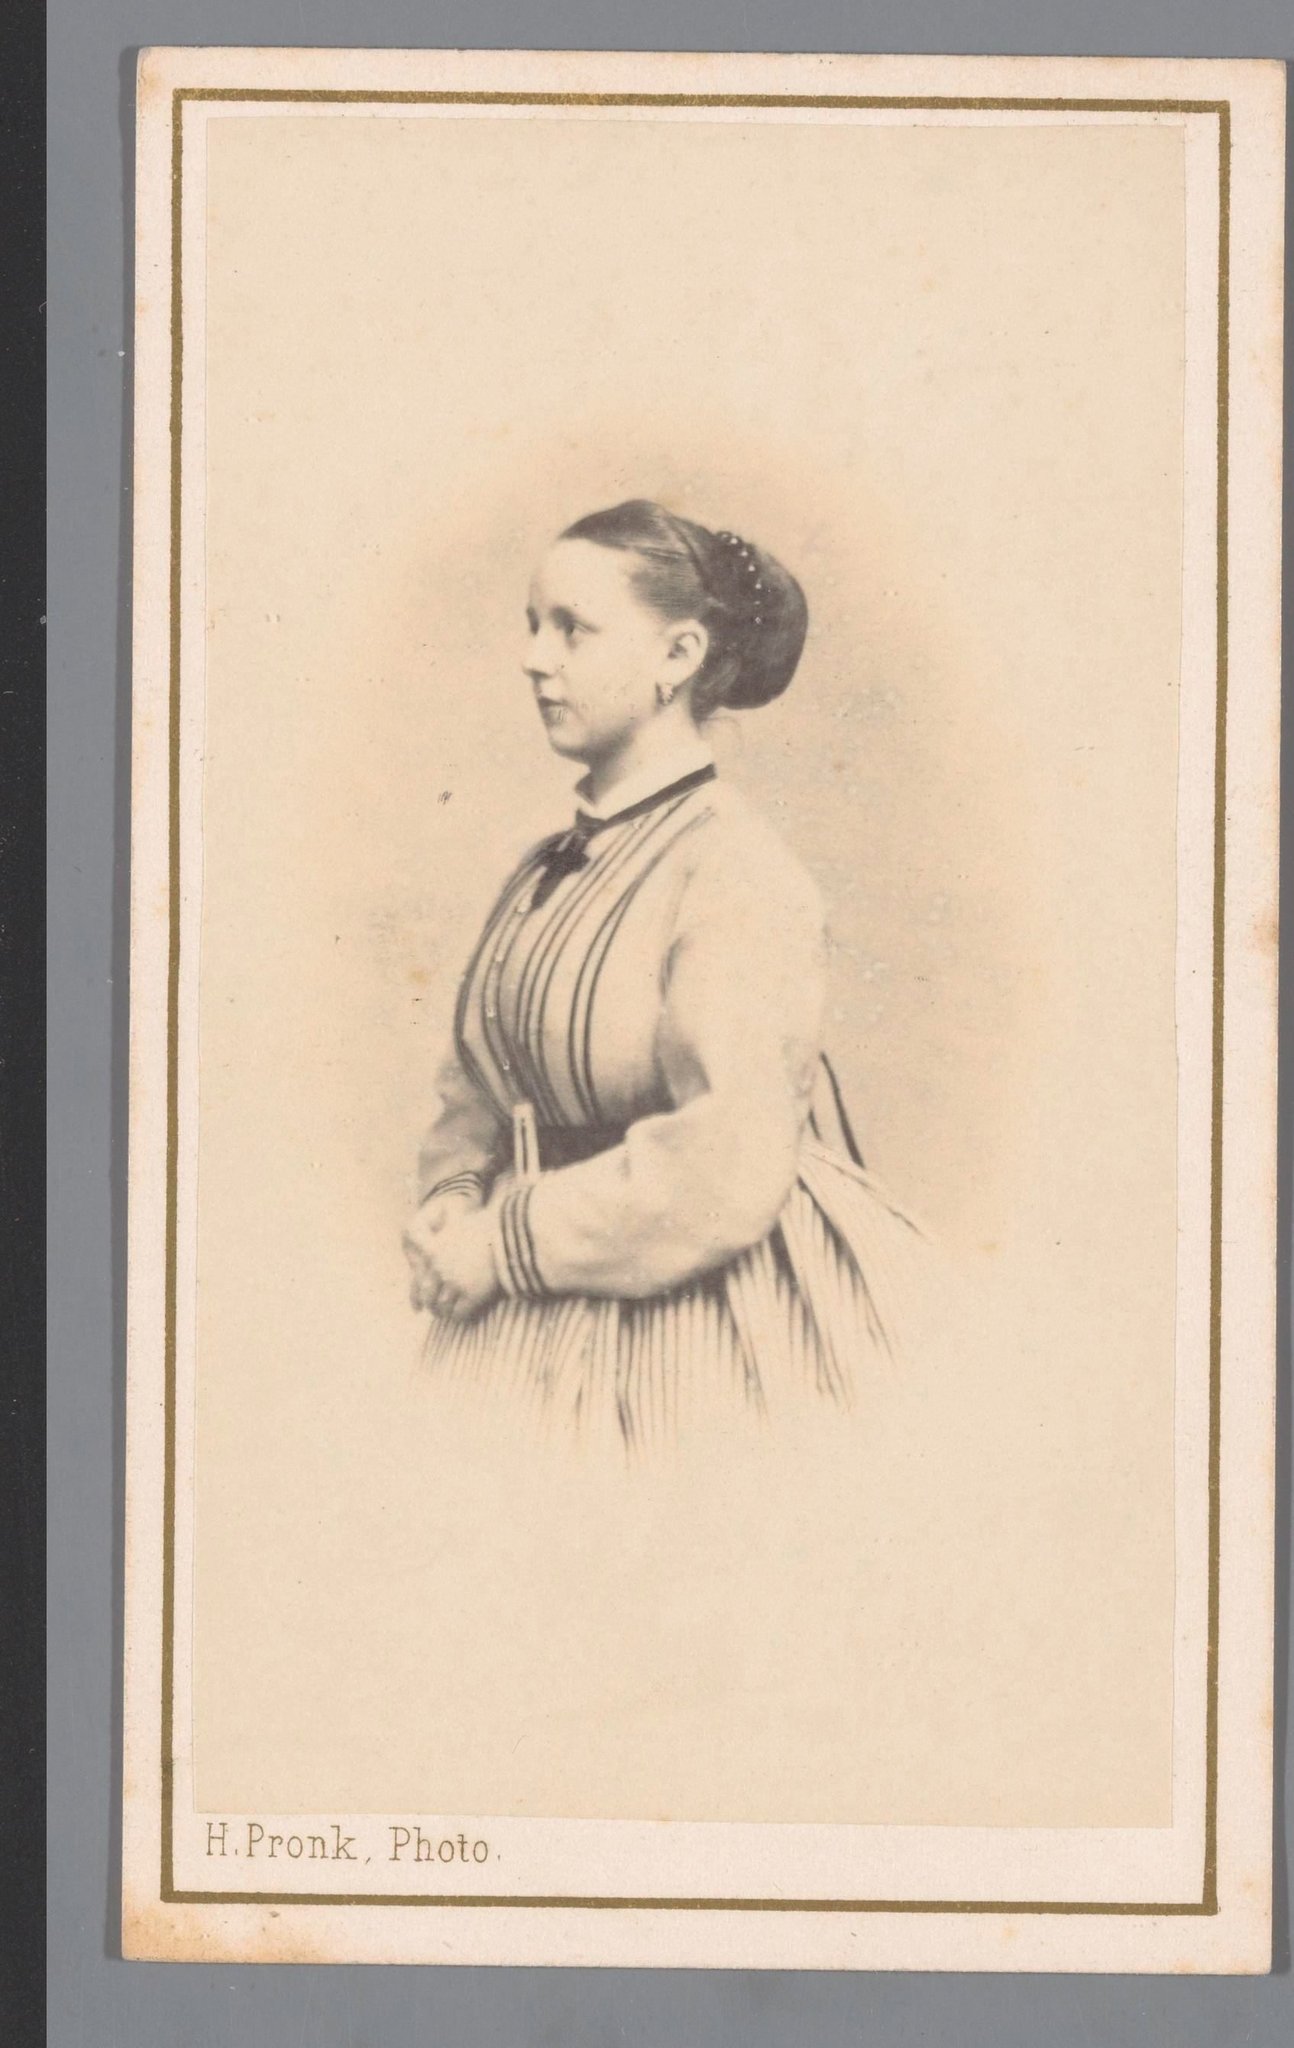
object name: carte de visite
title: Portret van een vrouw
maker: henri pronk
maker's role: fotograaf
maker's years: 1813-1893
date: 1866-1868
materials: cardboard, paper, photographic support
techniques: albumen print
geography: utrecht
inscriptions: address: ‘Henri Pronk/Photographe/Utrecht’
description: Staande vrouw met grote knot waaromheen kralen, en face naar links